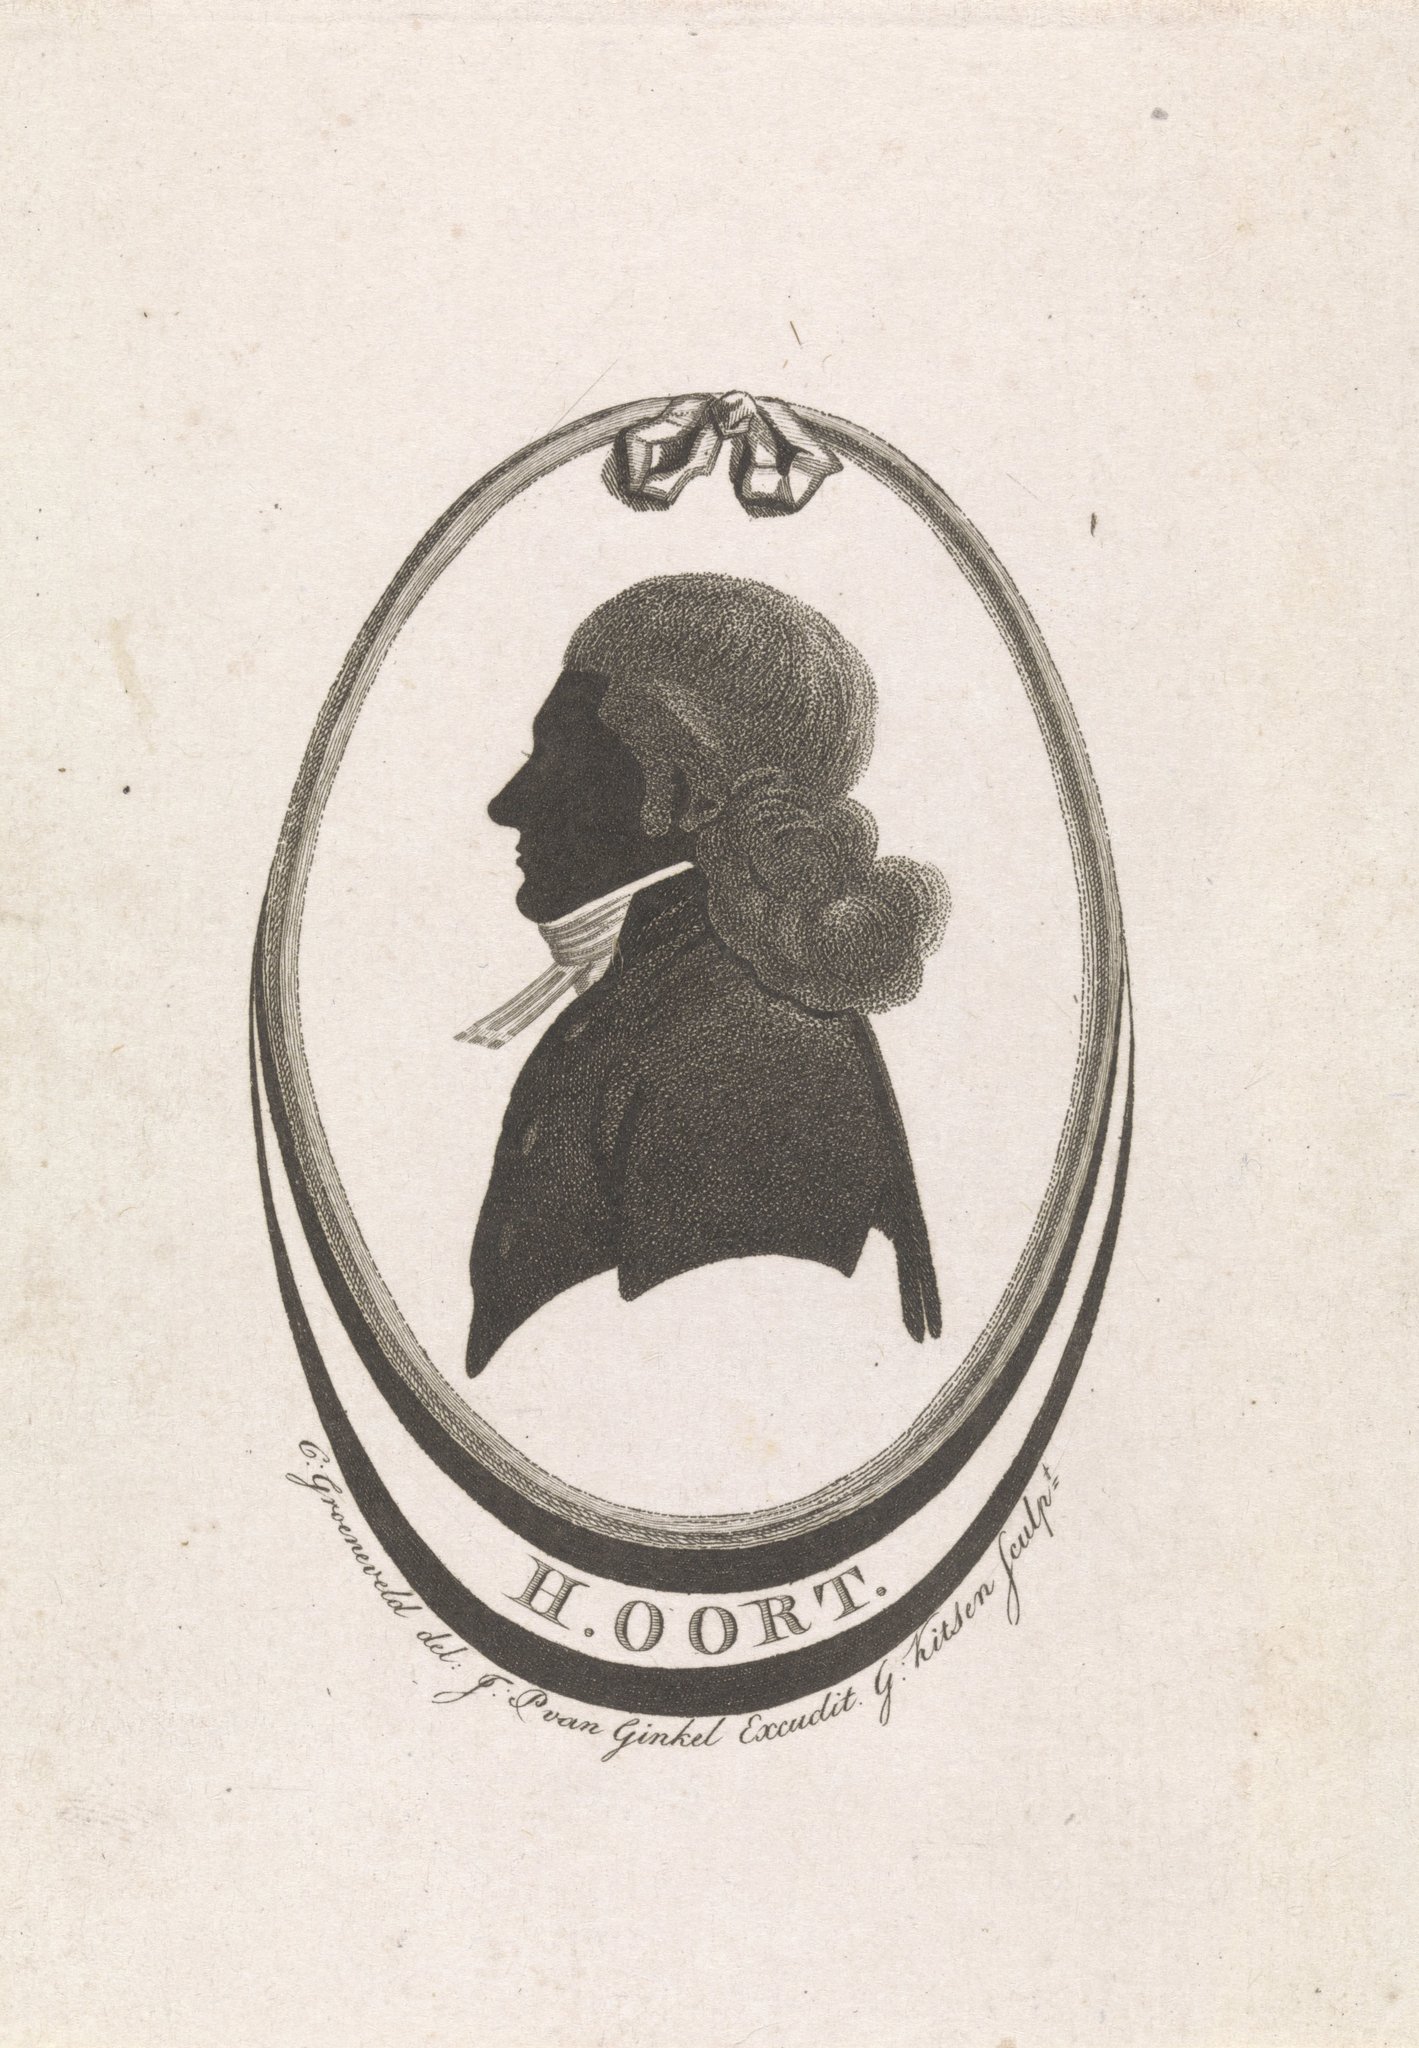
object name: print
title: Silhouetportret van Henricus Oort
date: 1776-1810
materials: paper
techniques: engraving, etching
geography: rotterdam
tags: rotterdam, wig (+ sideview, profile)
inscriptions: collector's mark: Lugt 2228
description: Portret van Henricus Oort, predikant te Zwolle en Hoogeveen. Hij draagt een toga en bef. Buste in profiel in ovale lijst met strik bovenaan.